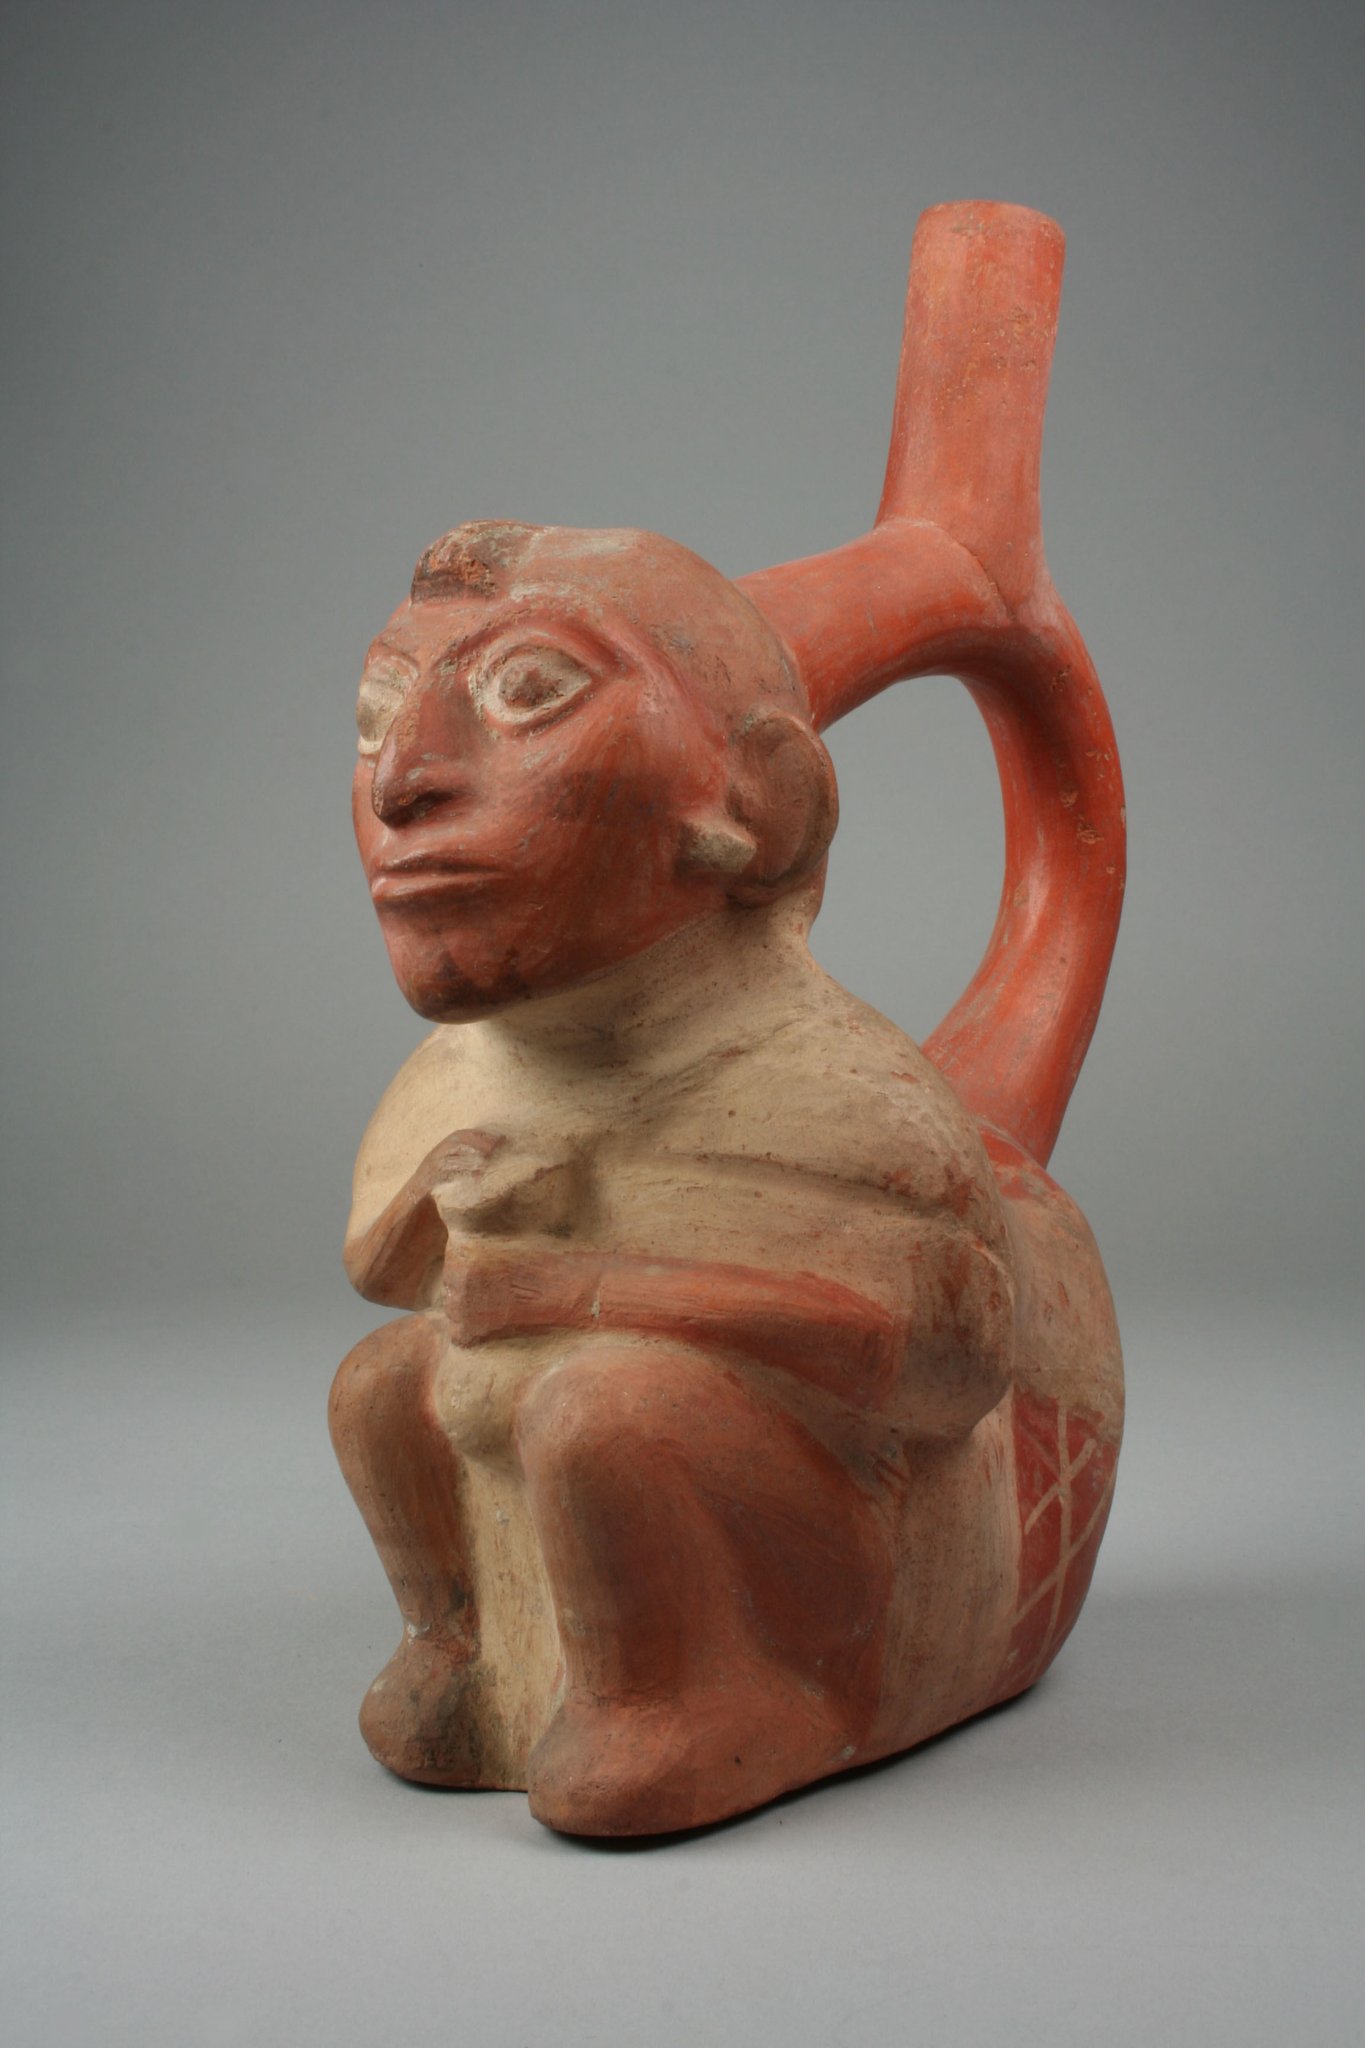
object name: bottle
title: Stirrup Spout Bottle with Figure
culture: moche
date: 301-700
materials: ceramic, pigment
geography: peru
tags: human figures